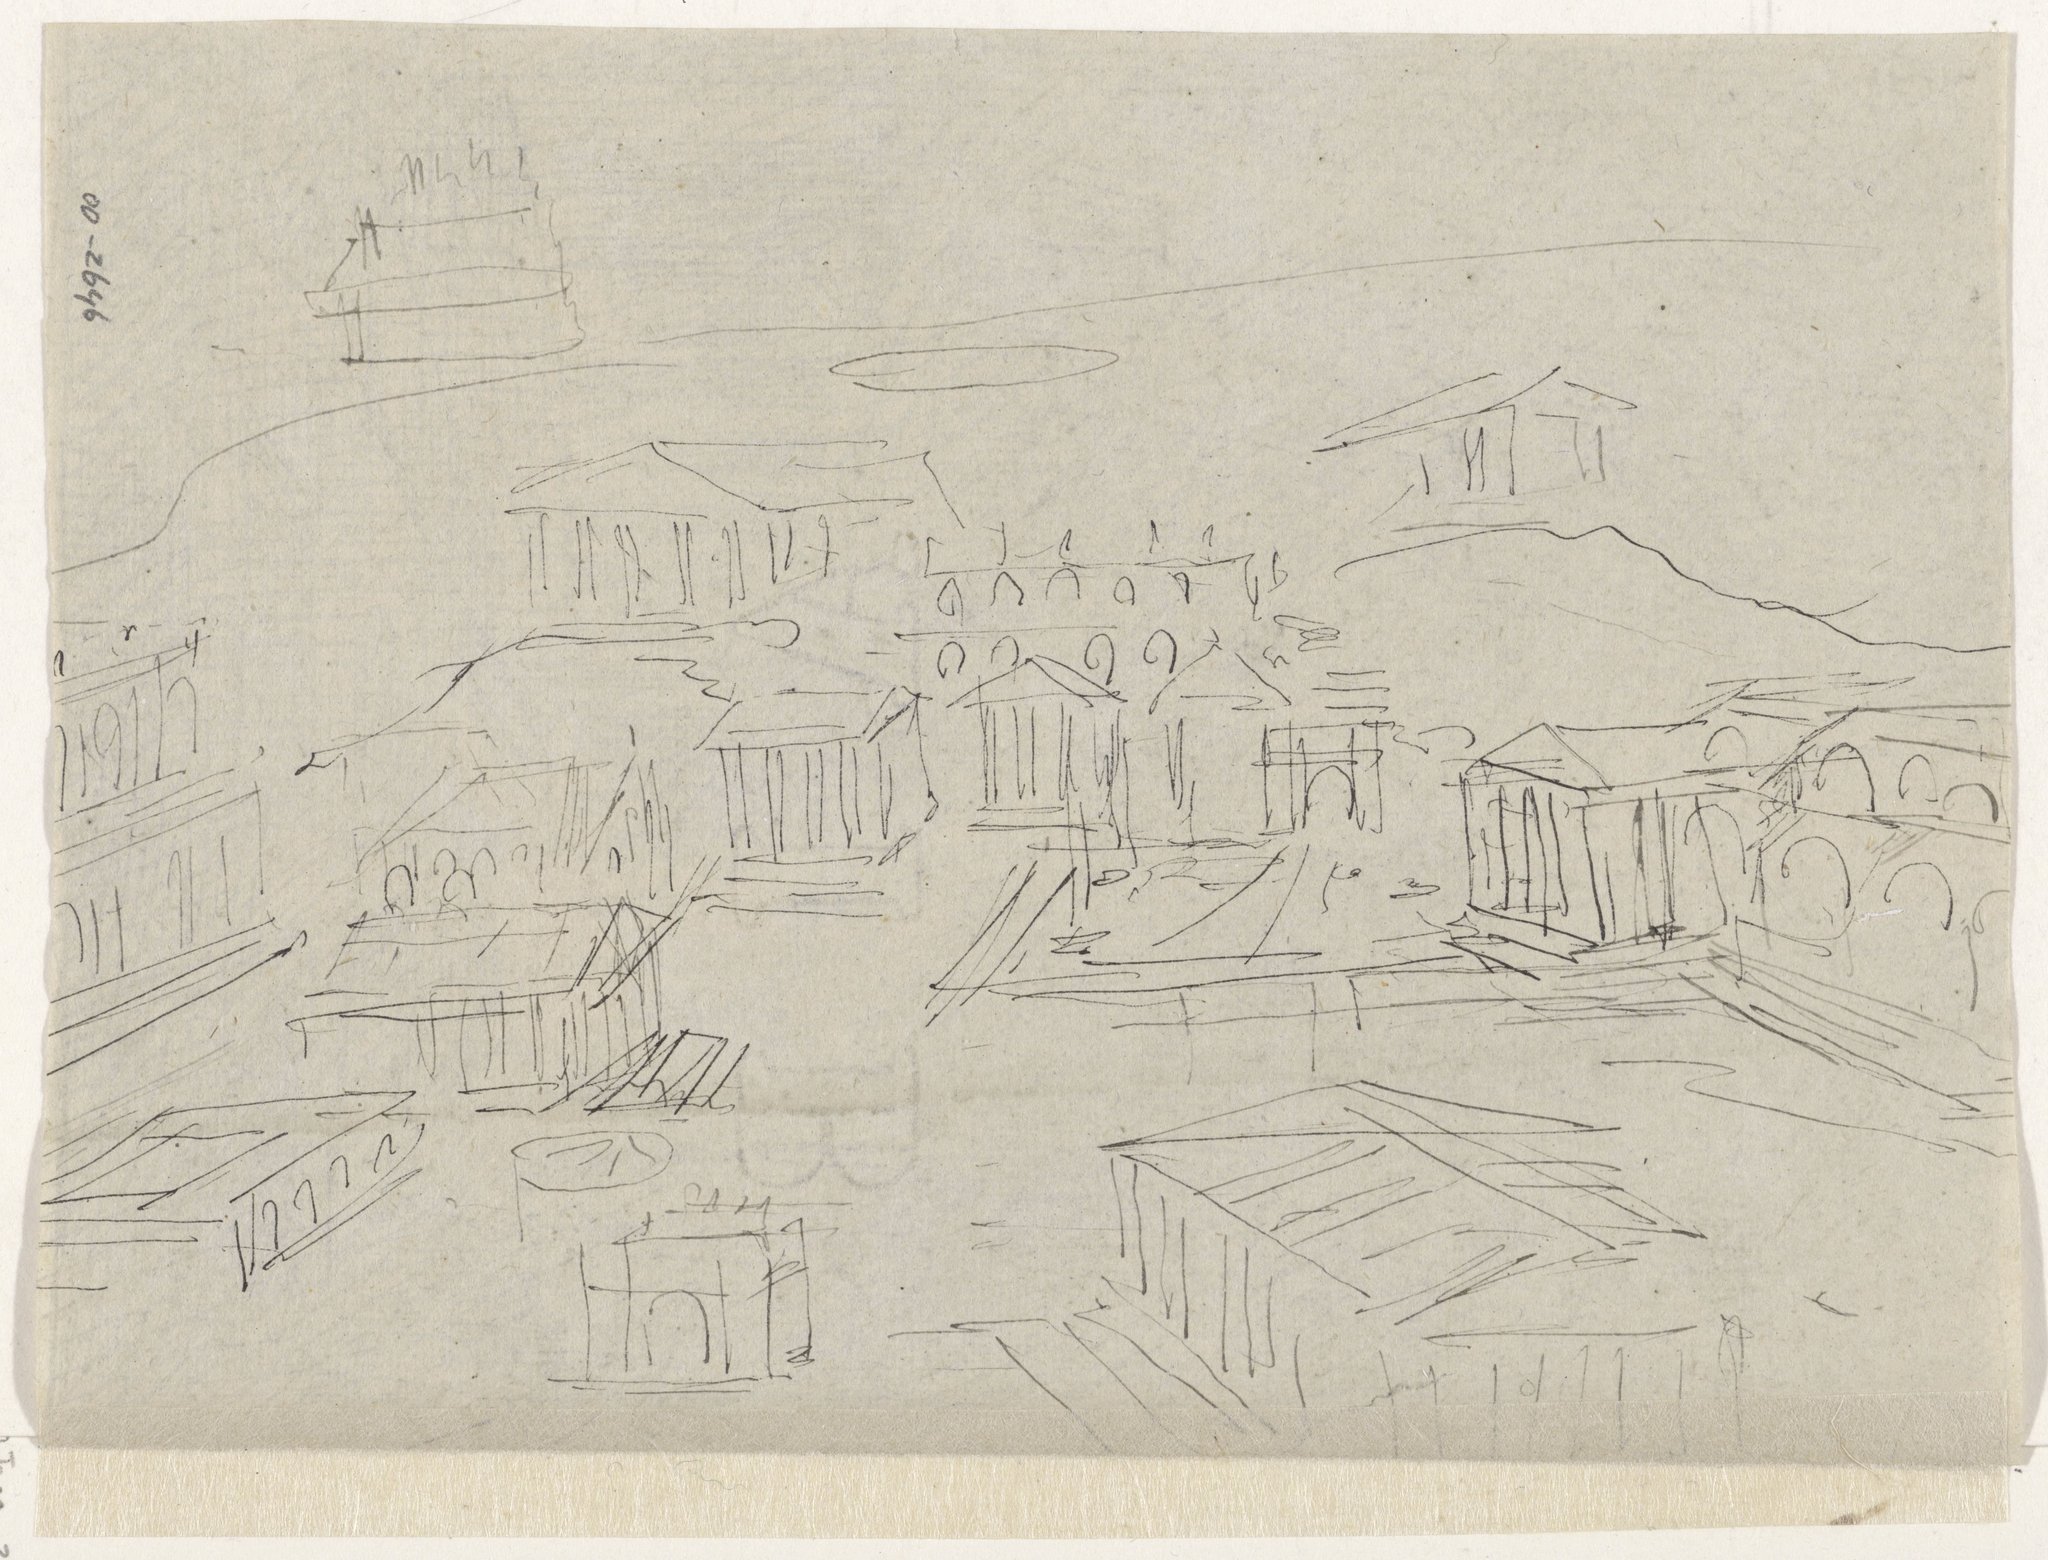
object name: drawing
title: Reconstructie van het Forum Romanum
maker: thomas cool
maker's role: draughtsman, painter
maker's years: 1851-1904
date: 1861-1904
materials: ink, paper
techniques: pen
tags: landscape with ruins, rome